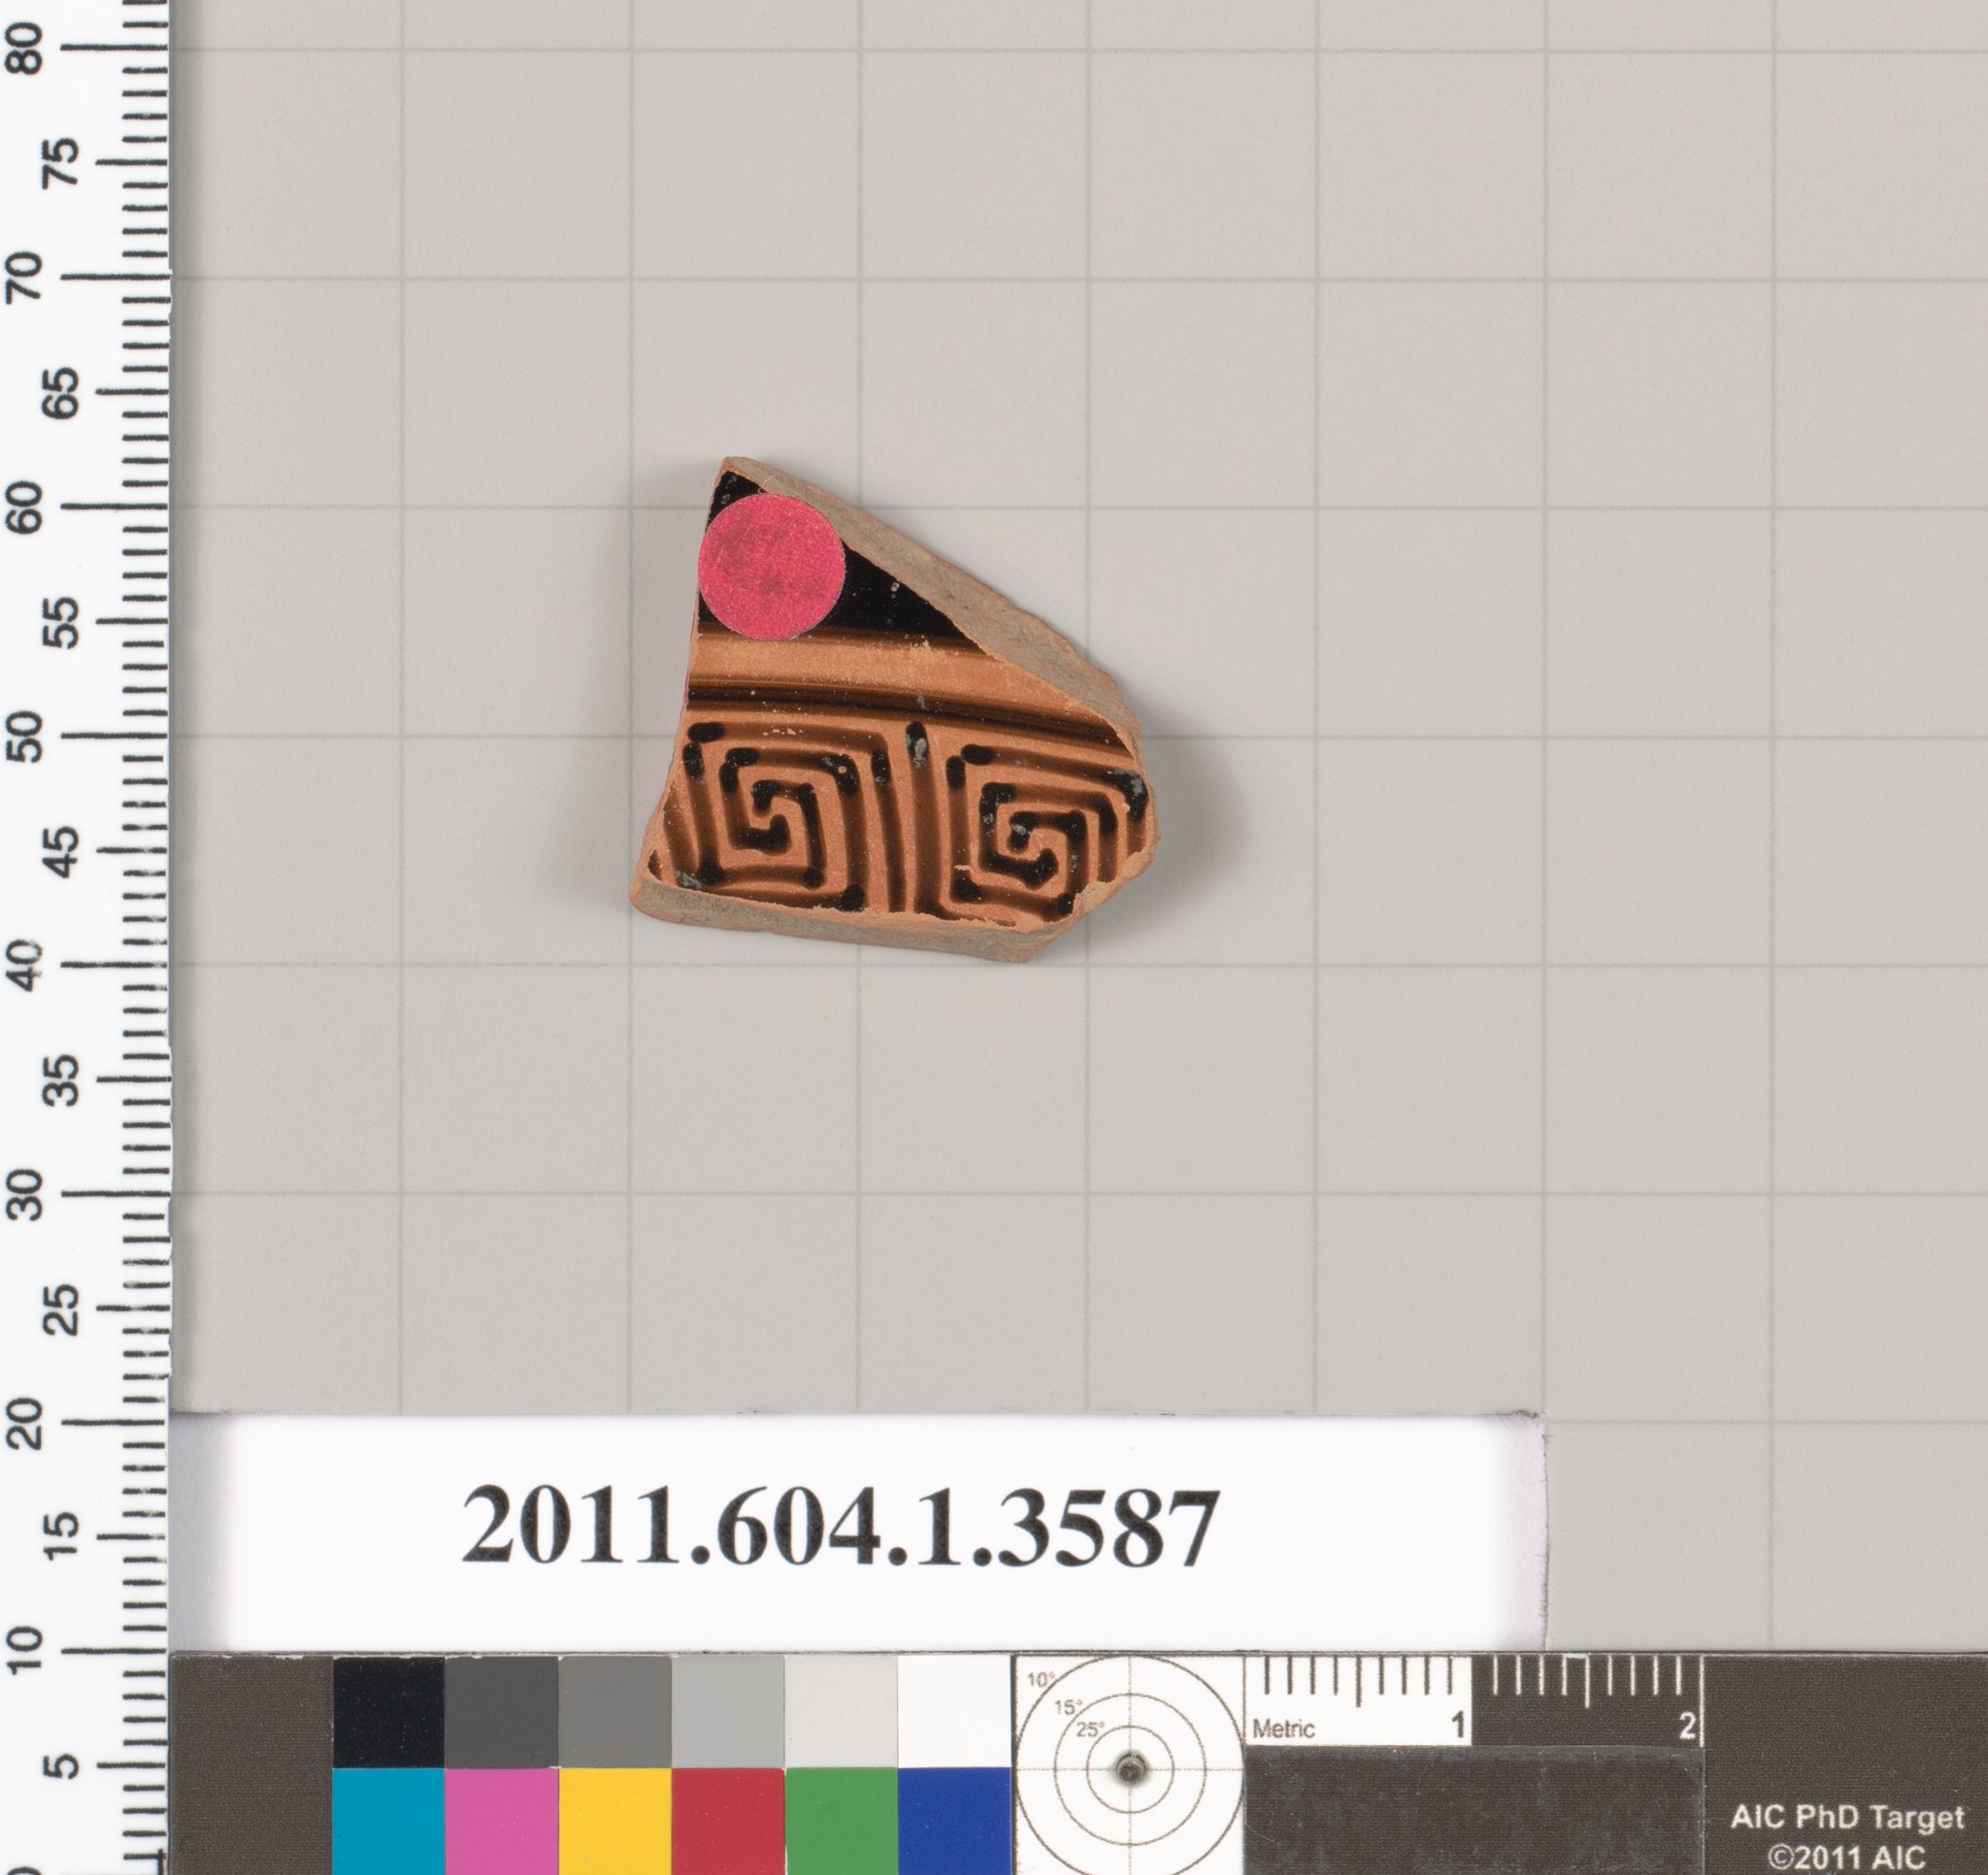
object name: kylix fragment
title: Terracotta fragment of a kylix (drinking cup)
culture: greek, attic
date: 475-451 BCE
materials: terracotta